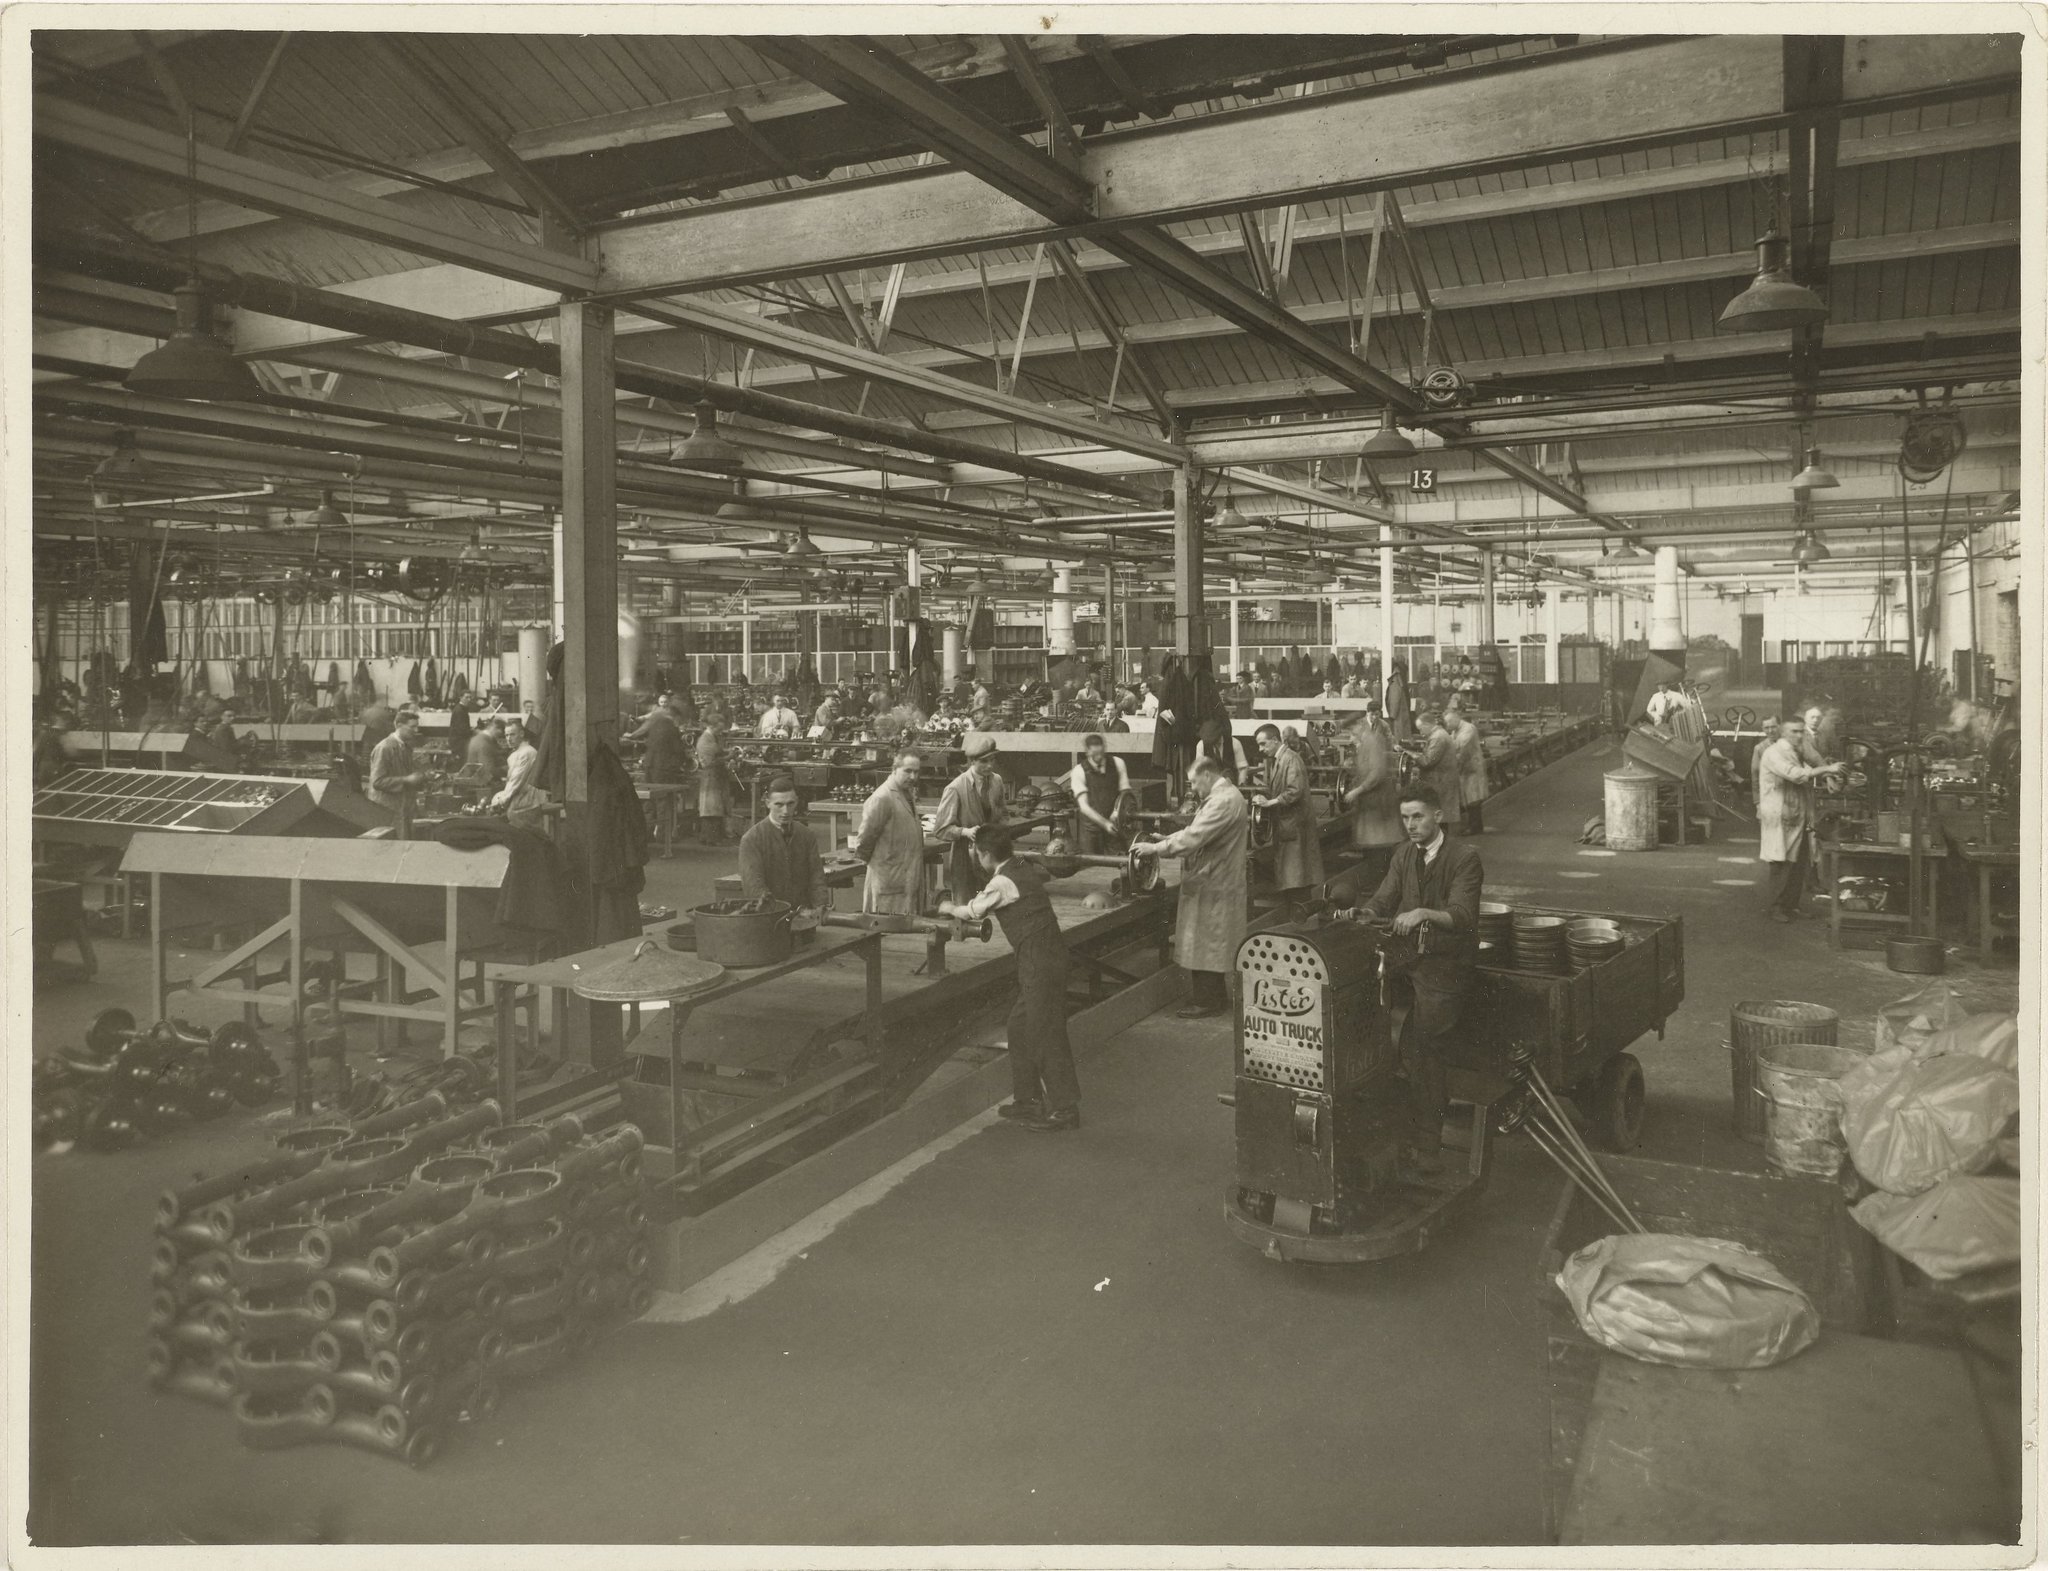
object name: photograph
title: Medewerkers van de Wolseley Motor Company in de Ward End Works, de fabriek in Birmingham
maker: f.r. logan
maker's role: fotograaf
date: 1932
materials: paper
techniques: gelatin silver print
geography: birmingham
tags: automobile, birmingham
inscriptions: address: ‘33 GT: CHARLES ST. B'HAM.’